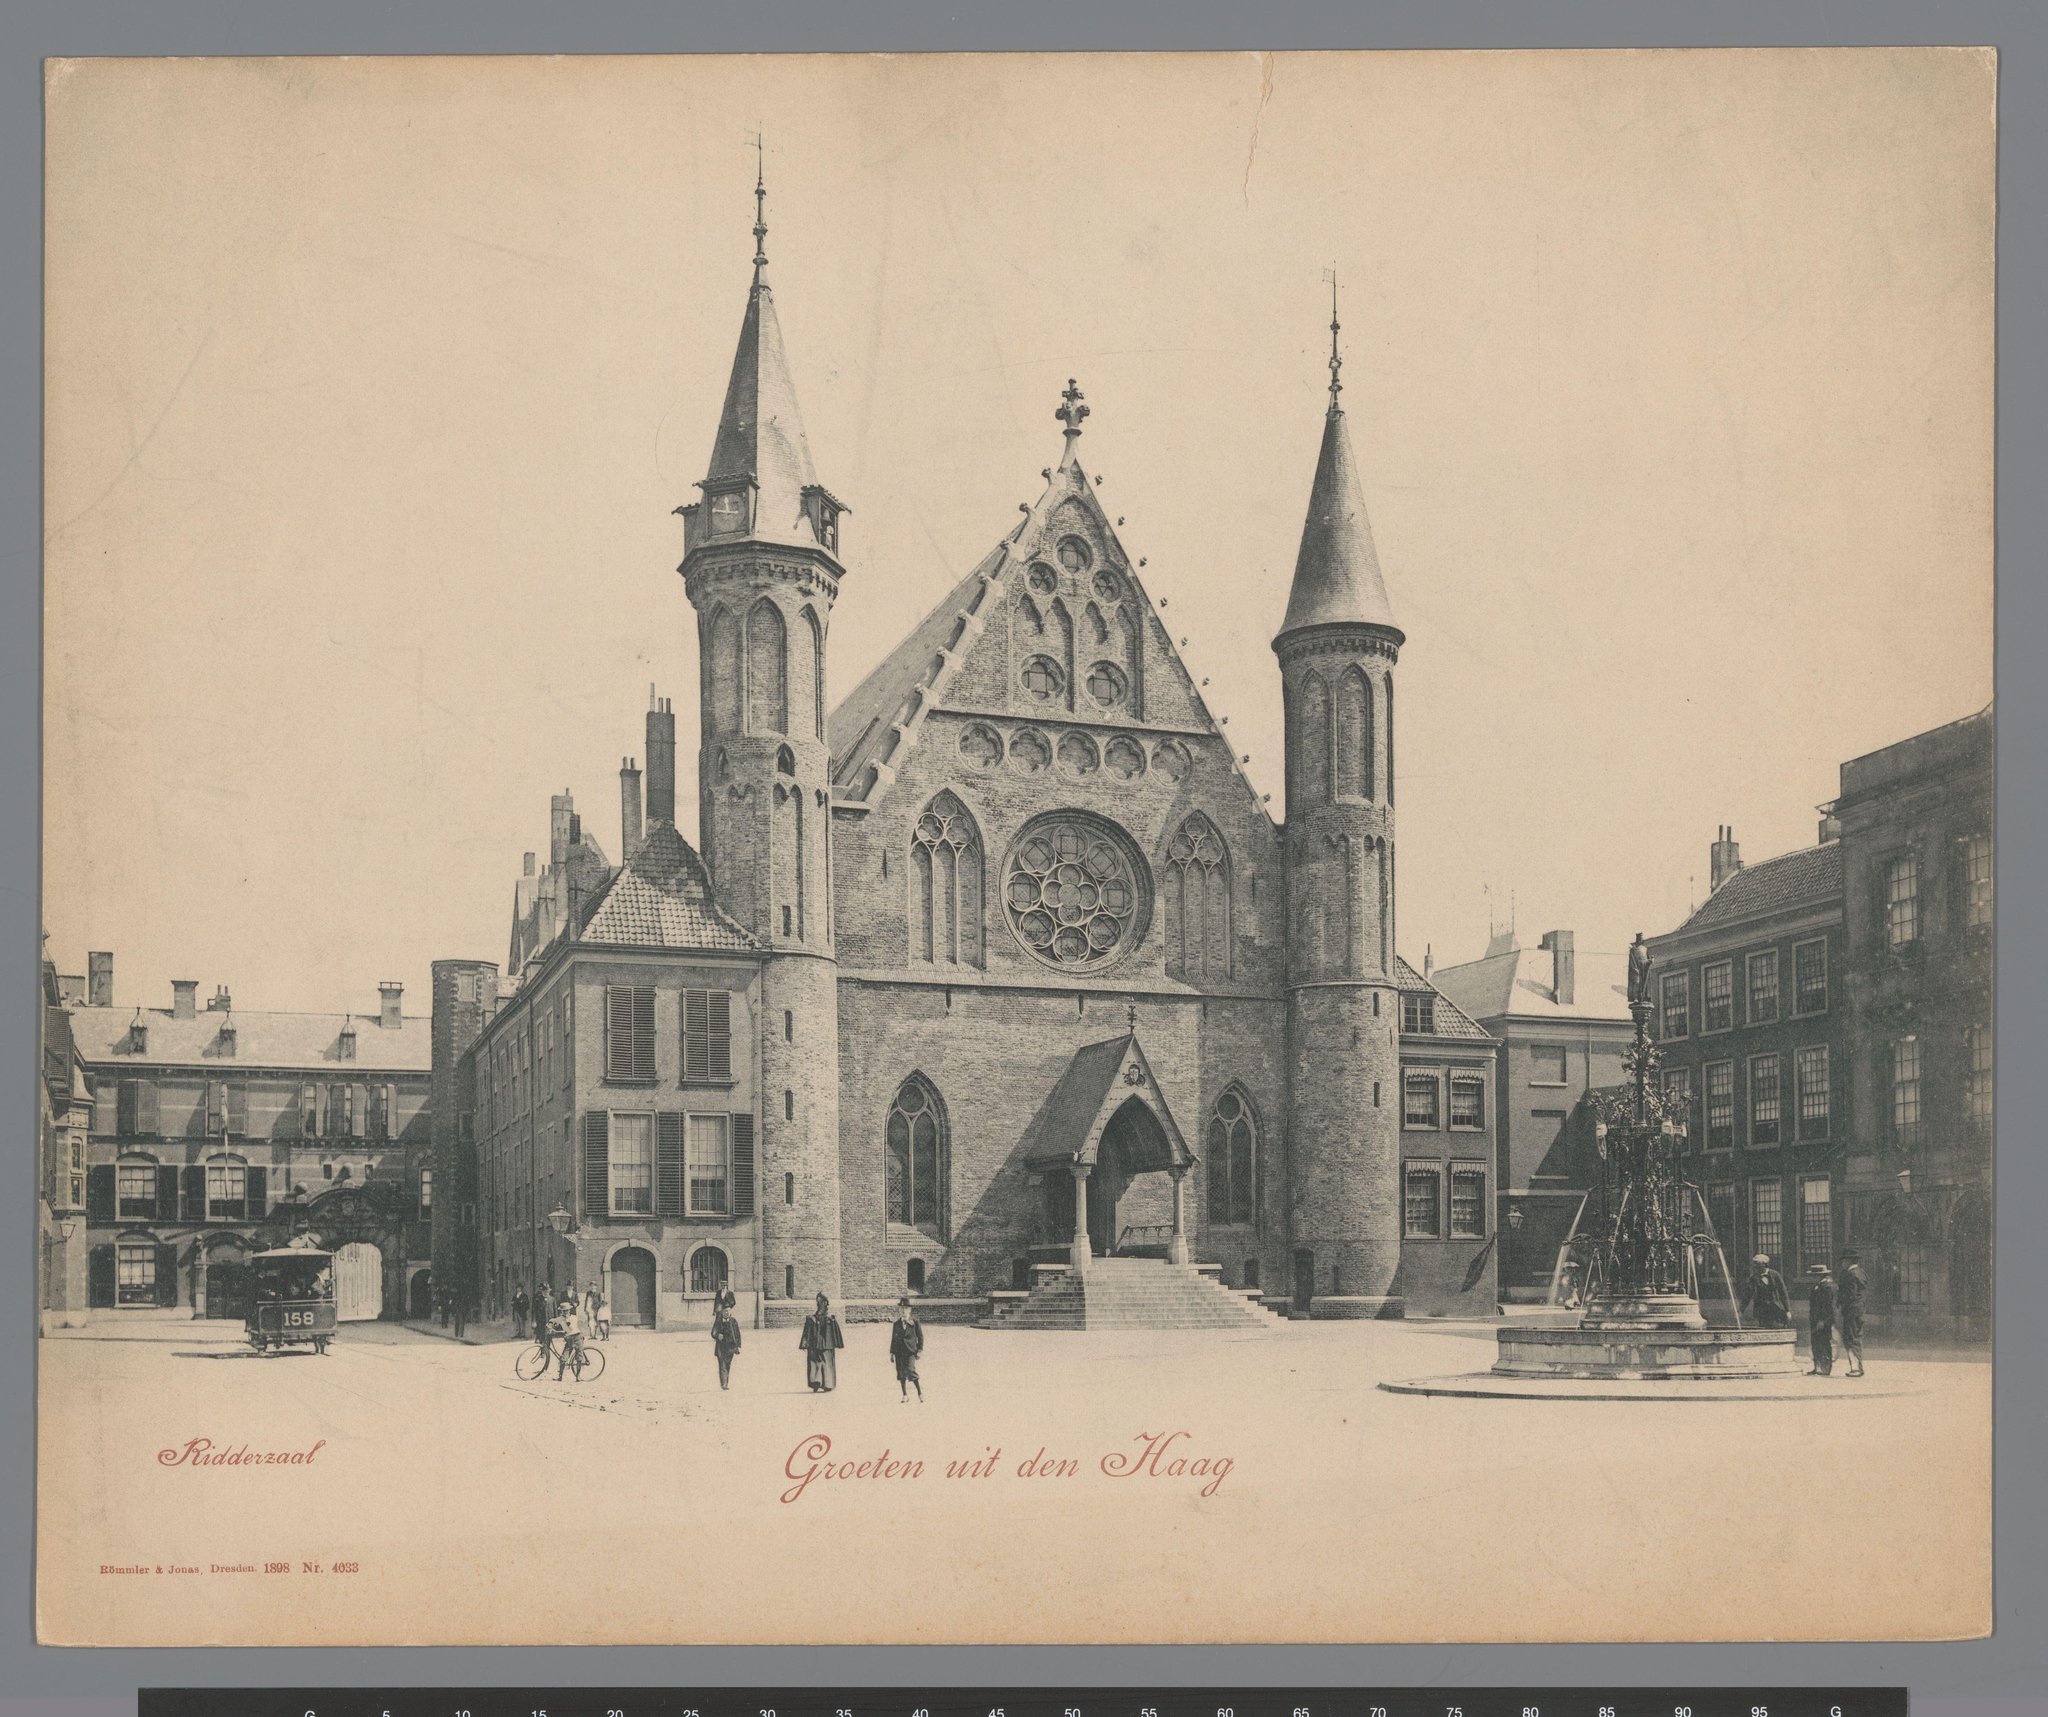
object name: ansichtkaart, prentbriefkaart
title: Groeten uit den Haag; Ridderzaal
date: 1898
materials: paper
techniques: photograph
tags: city-view, and landscape with man-made constructions, the hague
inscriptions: date